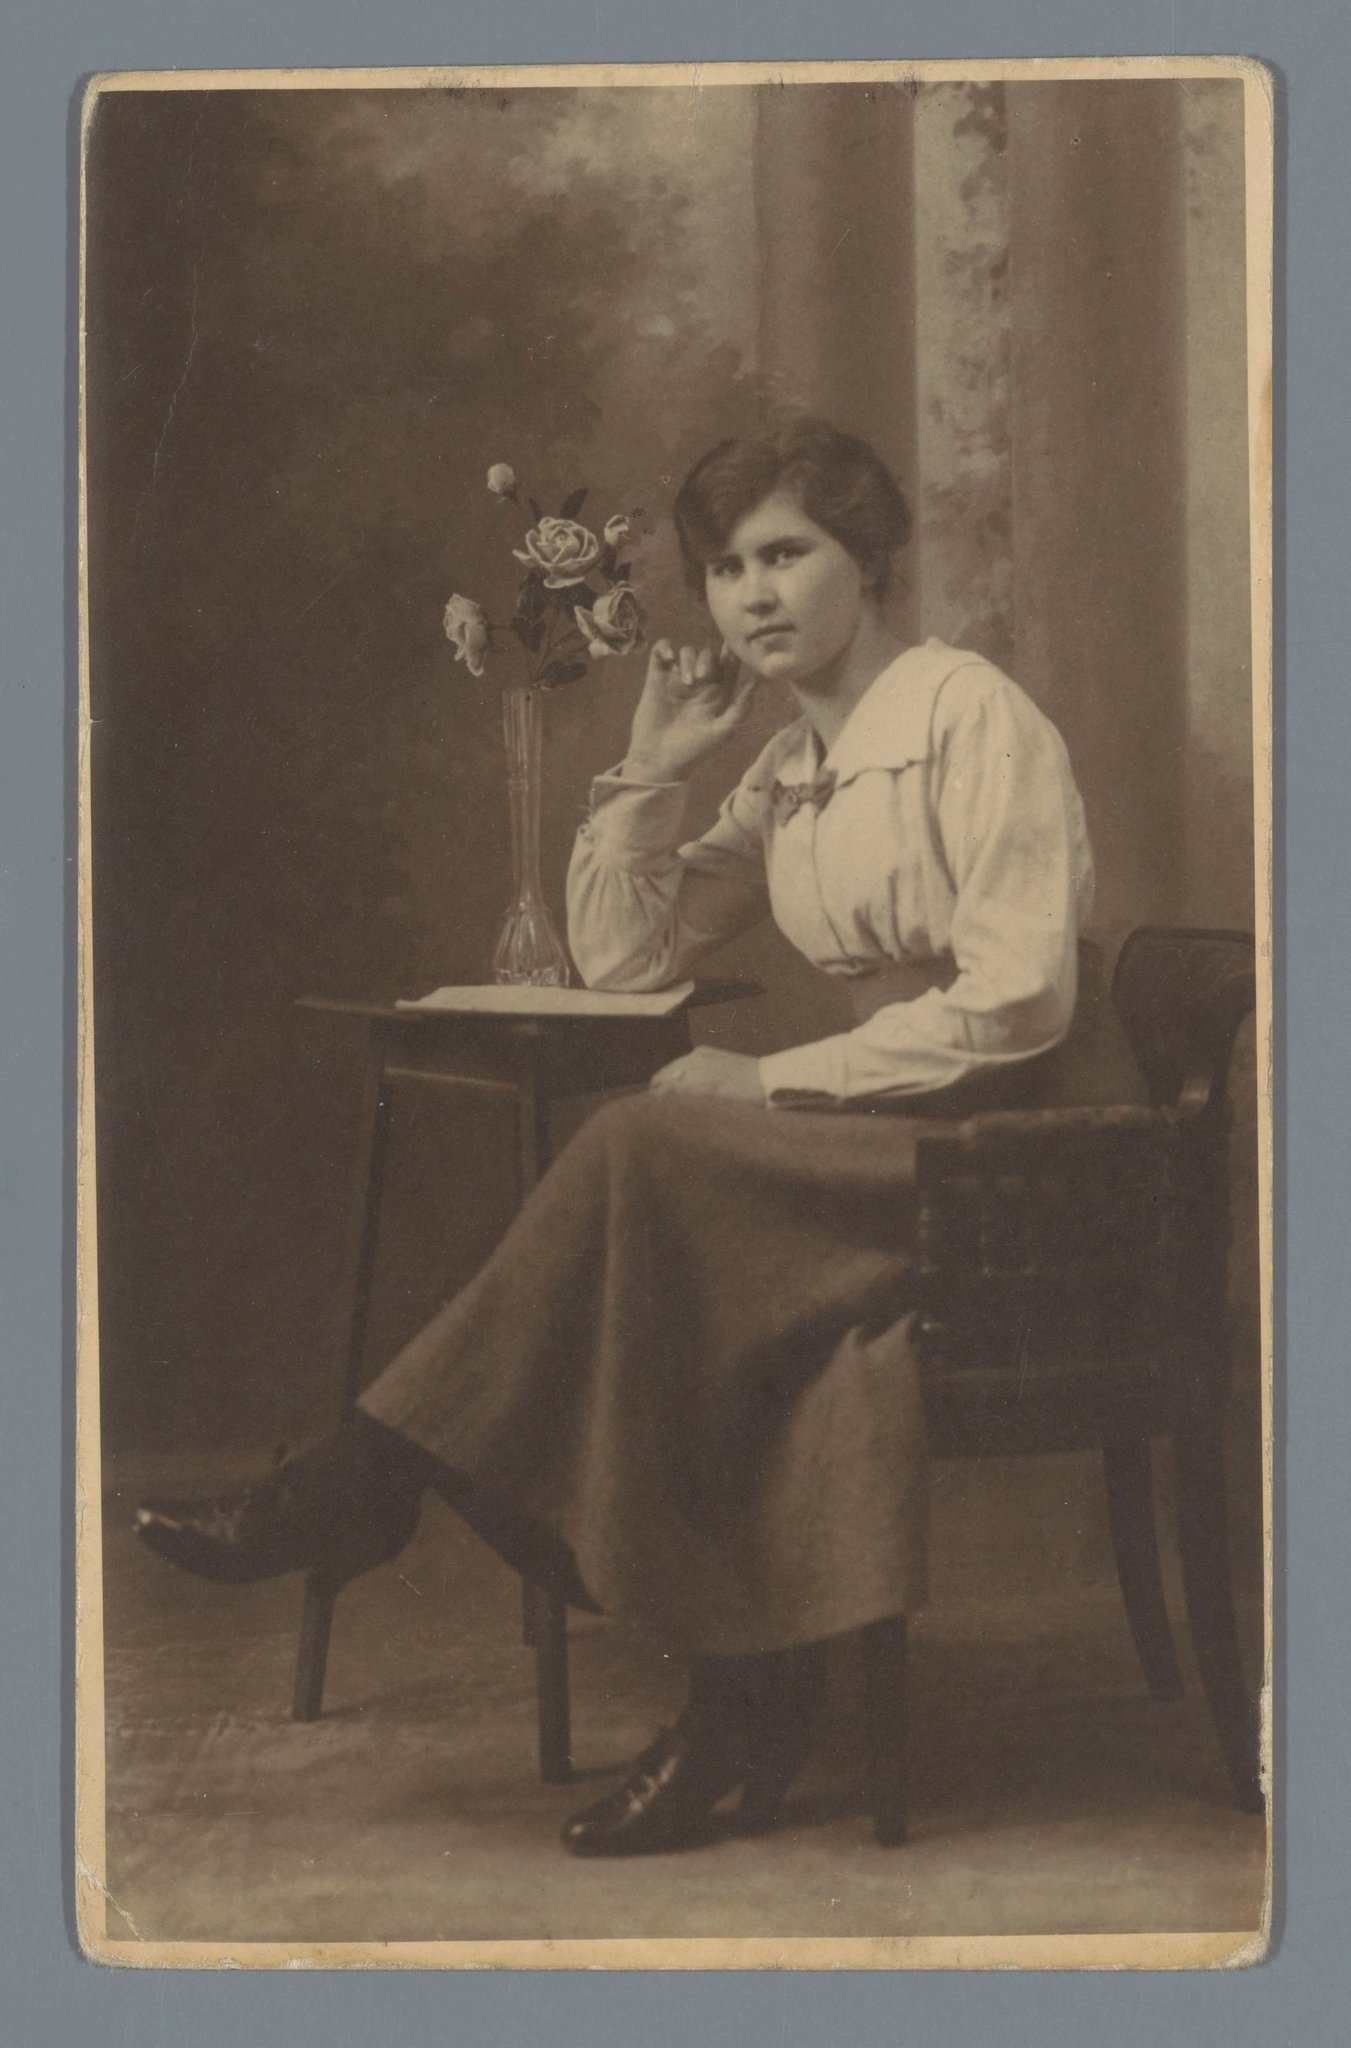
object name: ansichtkaart, prentbriefkaart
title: Studioportret van een onbekende vrouw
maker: Anonymous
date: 1907-1920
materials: photographic support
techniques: gelatin silver print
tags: studio ~ photographer, adult woman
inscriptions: number: ‘44595’